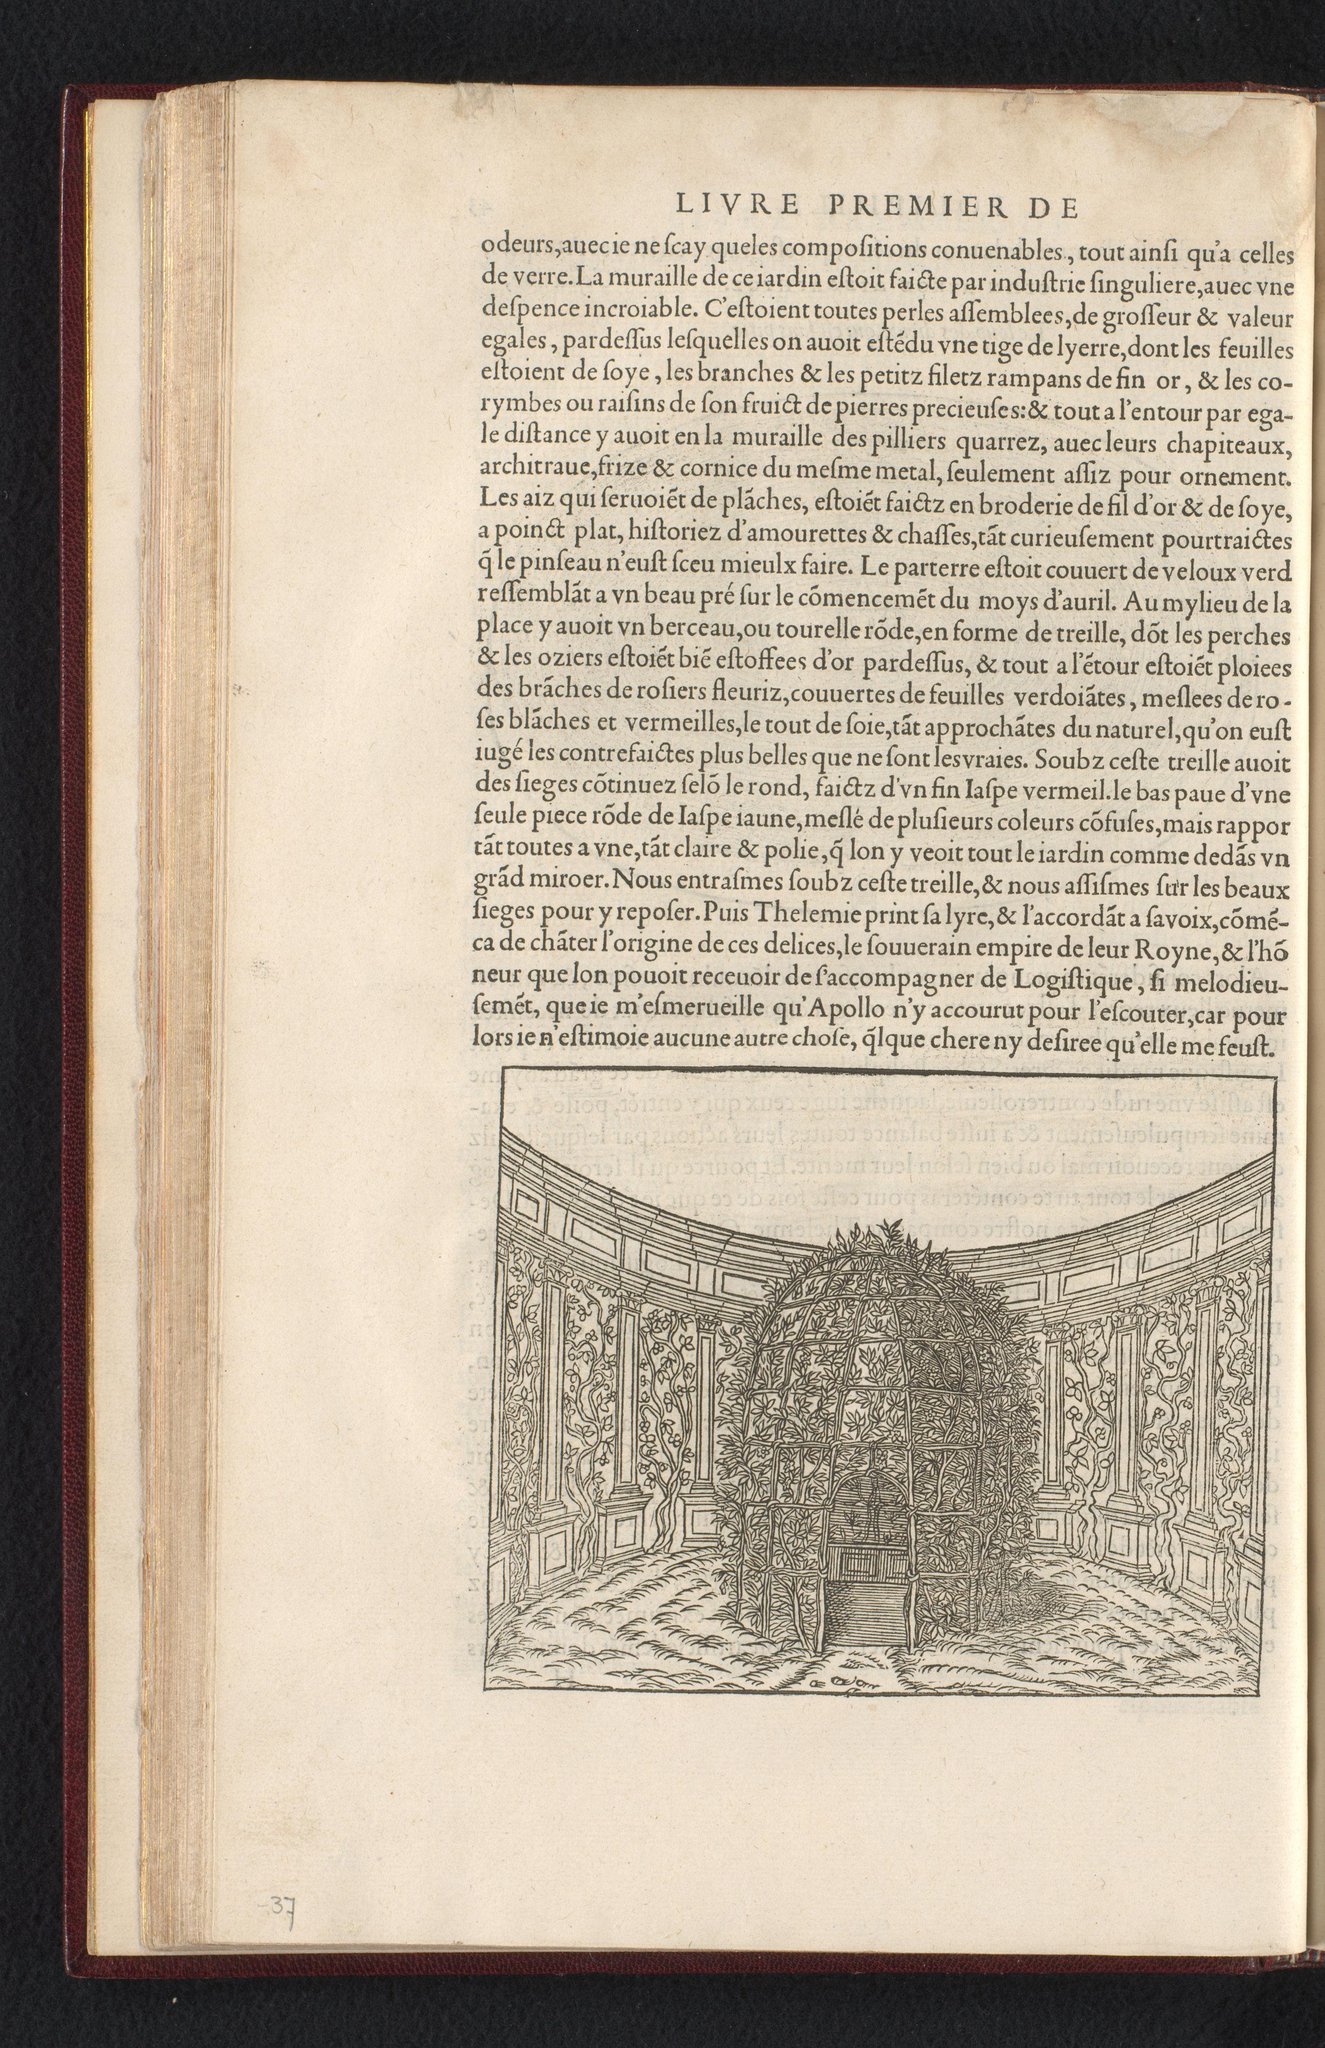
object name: print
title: Prieel omgeven door een begroeide muur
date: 1546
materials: paper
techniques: letterpress printing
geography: paris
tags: (scenes from) specific works of literature: colonna, hypnerotomachia poliphili, garden buildings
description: Prent uit: Colonna, Francesco. Hypnerotomachie ou discours du songe de Poliphile, deduisant comme amour le combat a l'occasion de Polia. Parijs: Jacques Kerver, 1546, verso fol. 43.